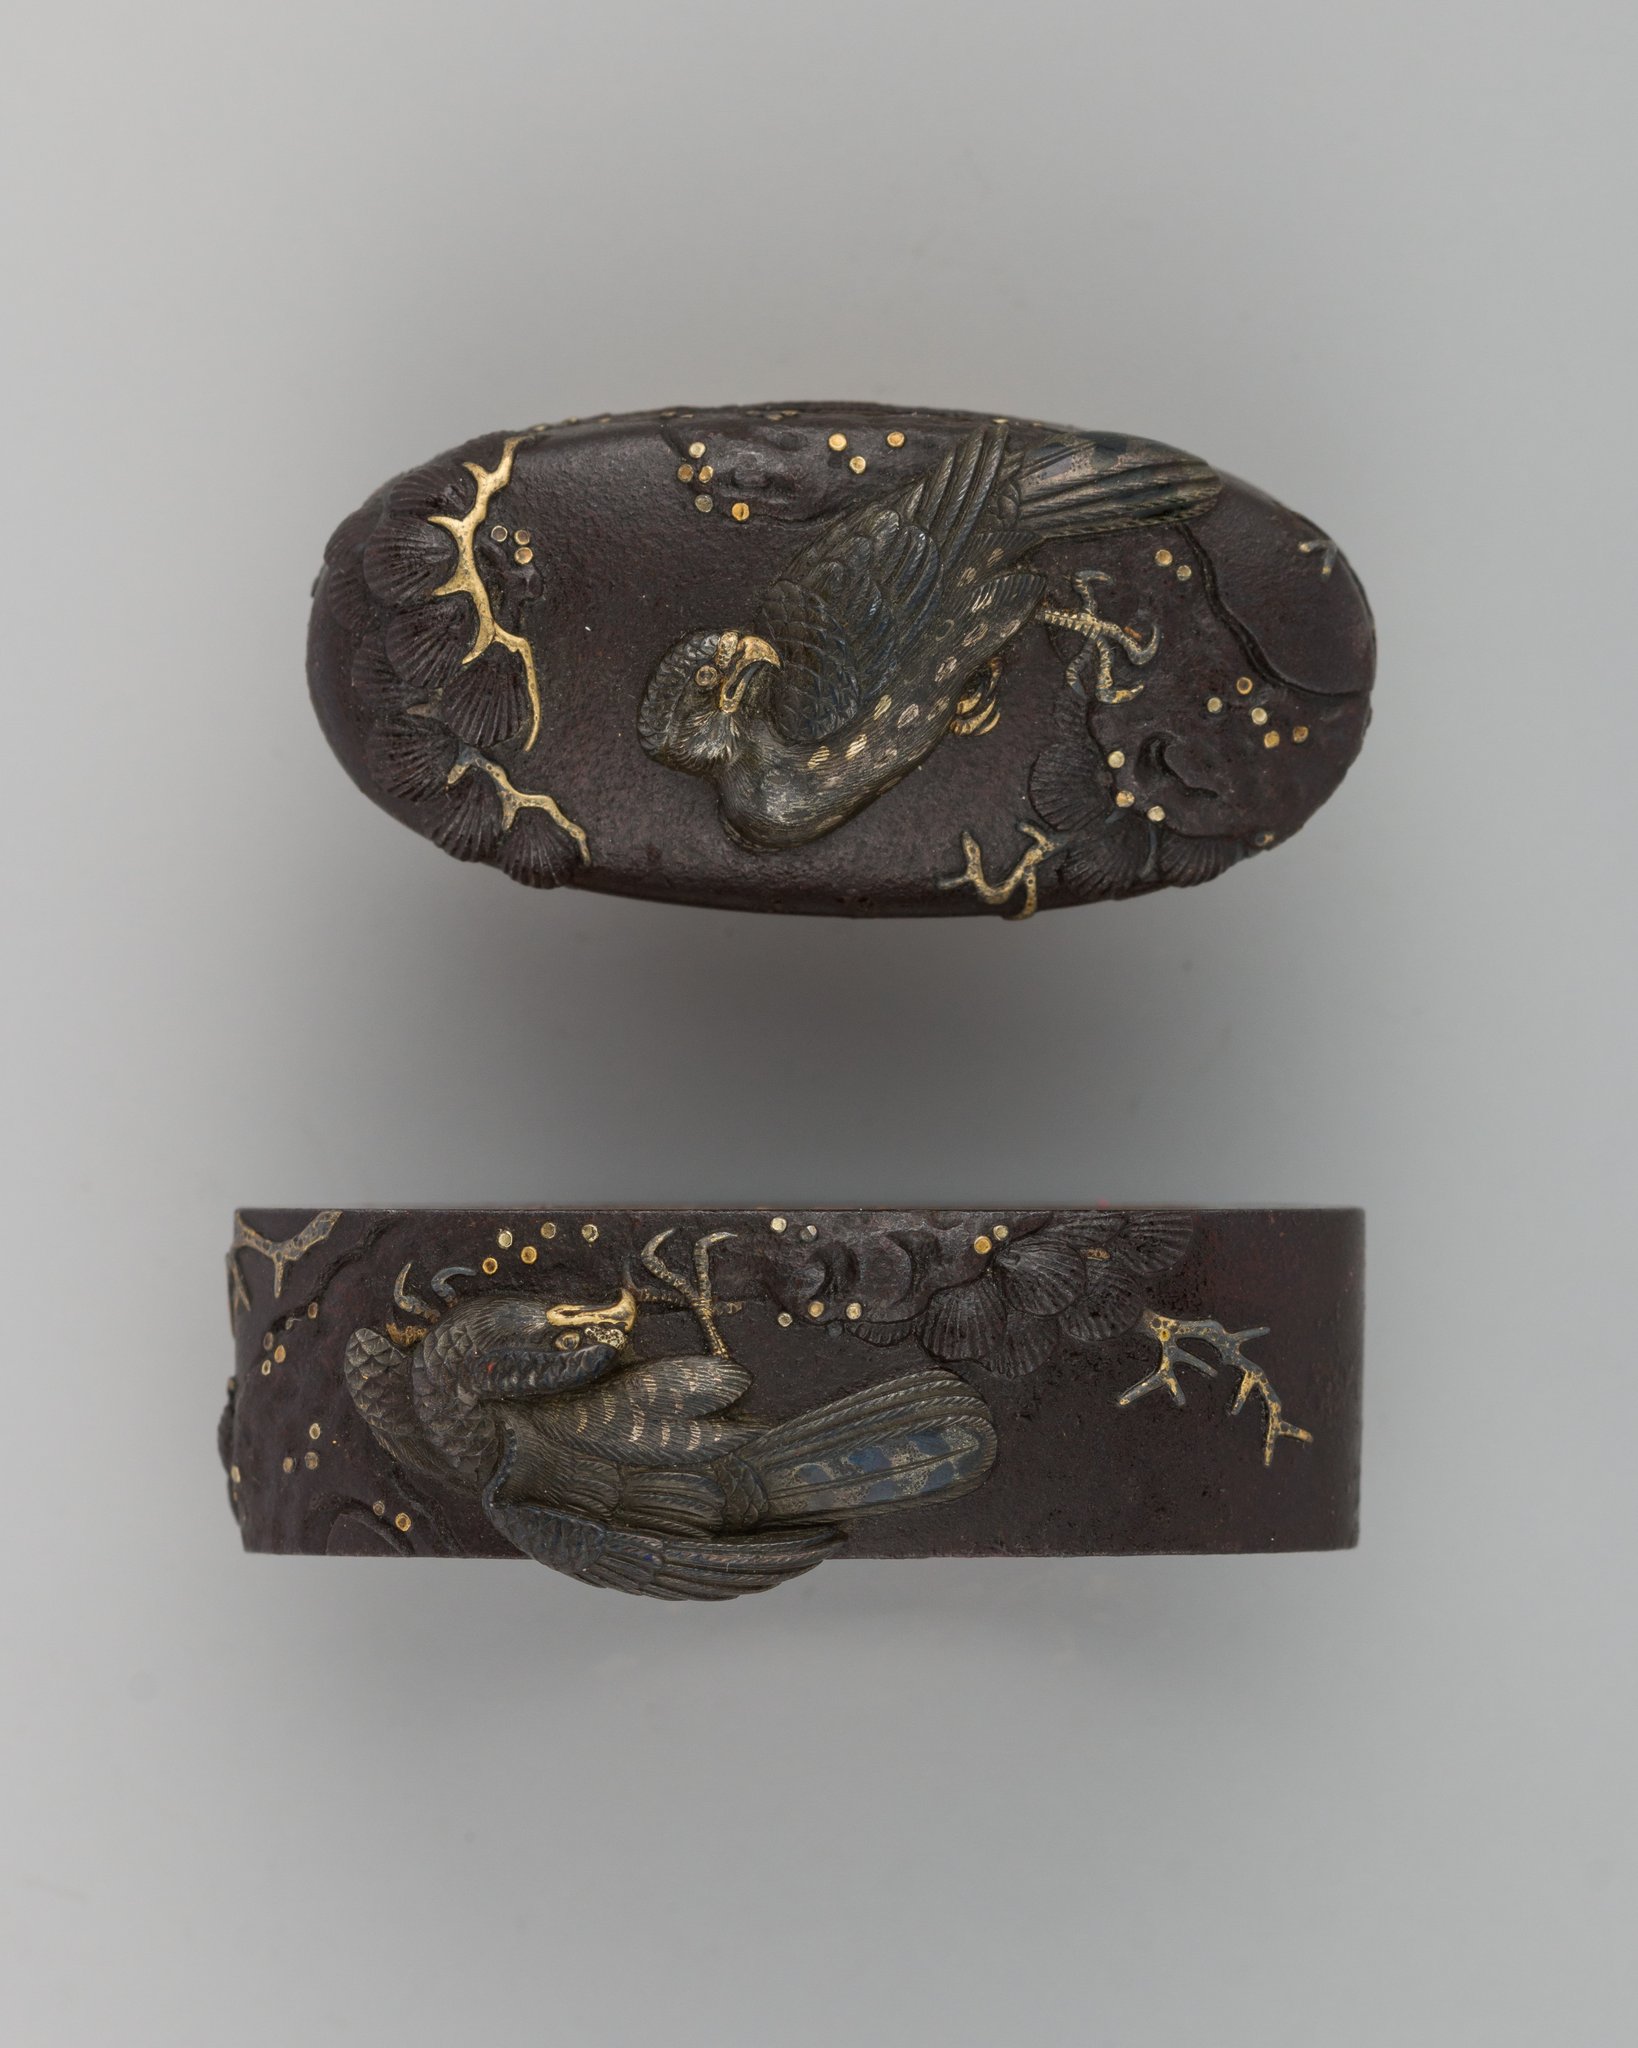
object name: sword hilt collar and pommel fuchigashira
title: Sword-Hilt Collar and Pommel (Fuchigashira)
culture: japanese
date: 1615-1868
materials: silver alloy, gold, iron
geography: japan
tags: birds